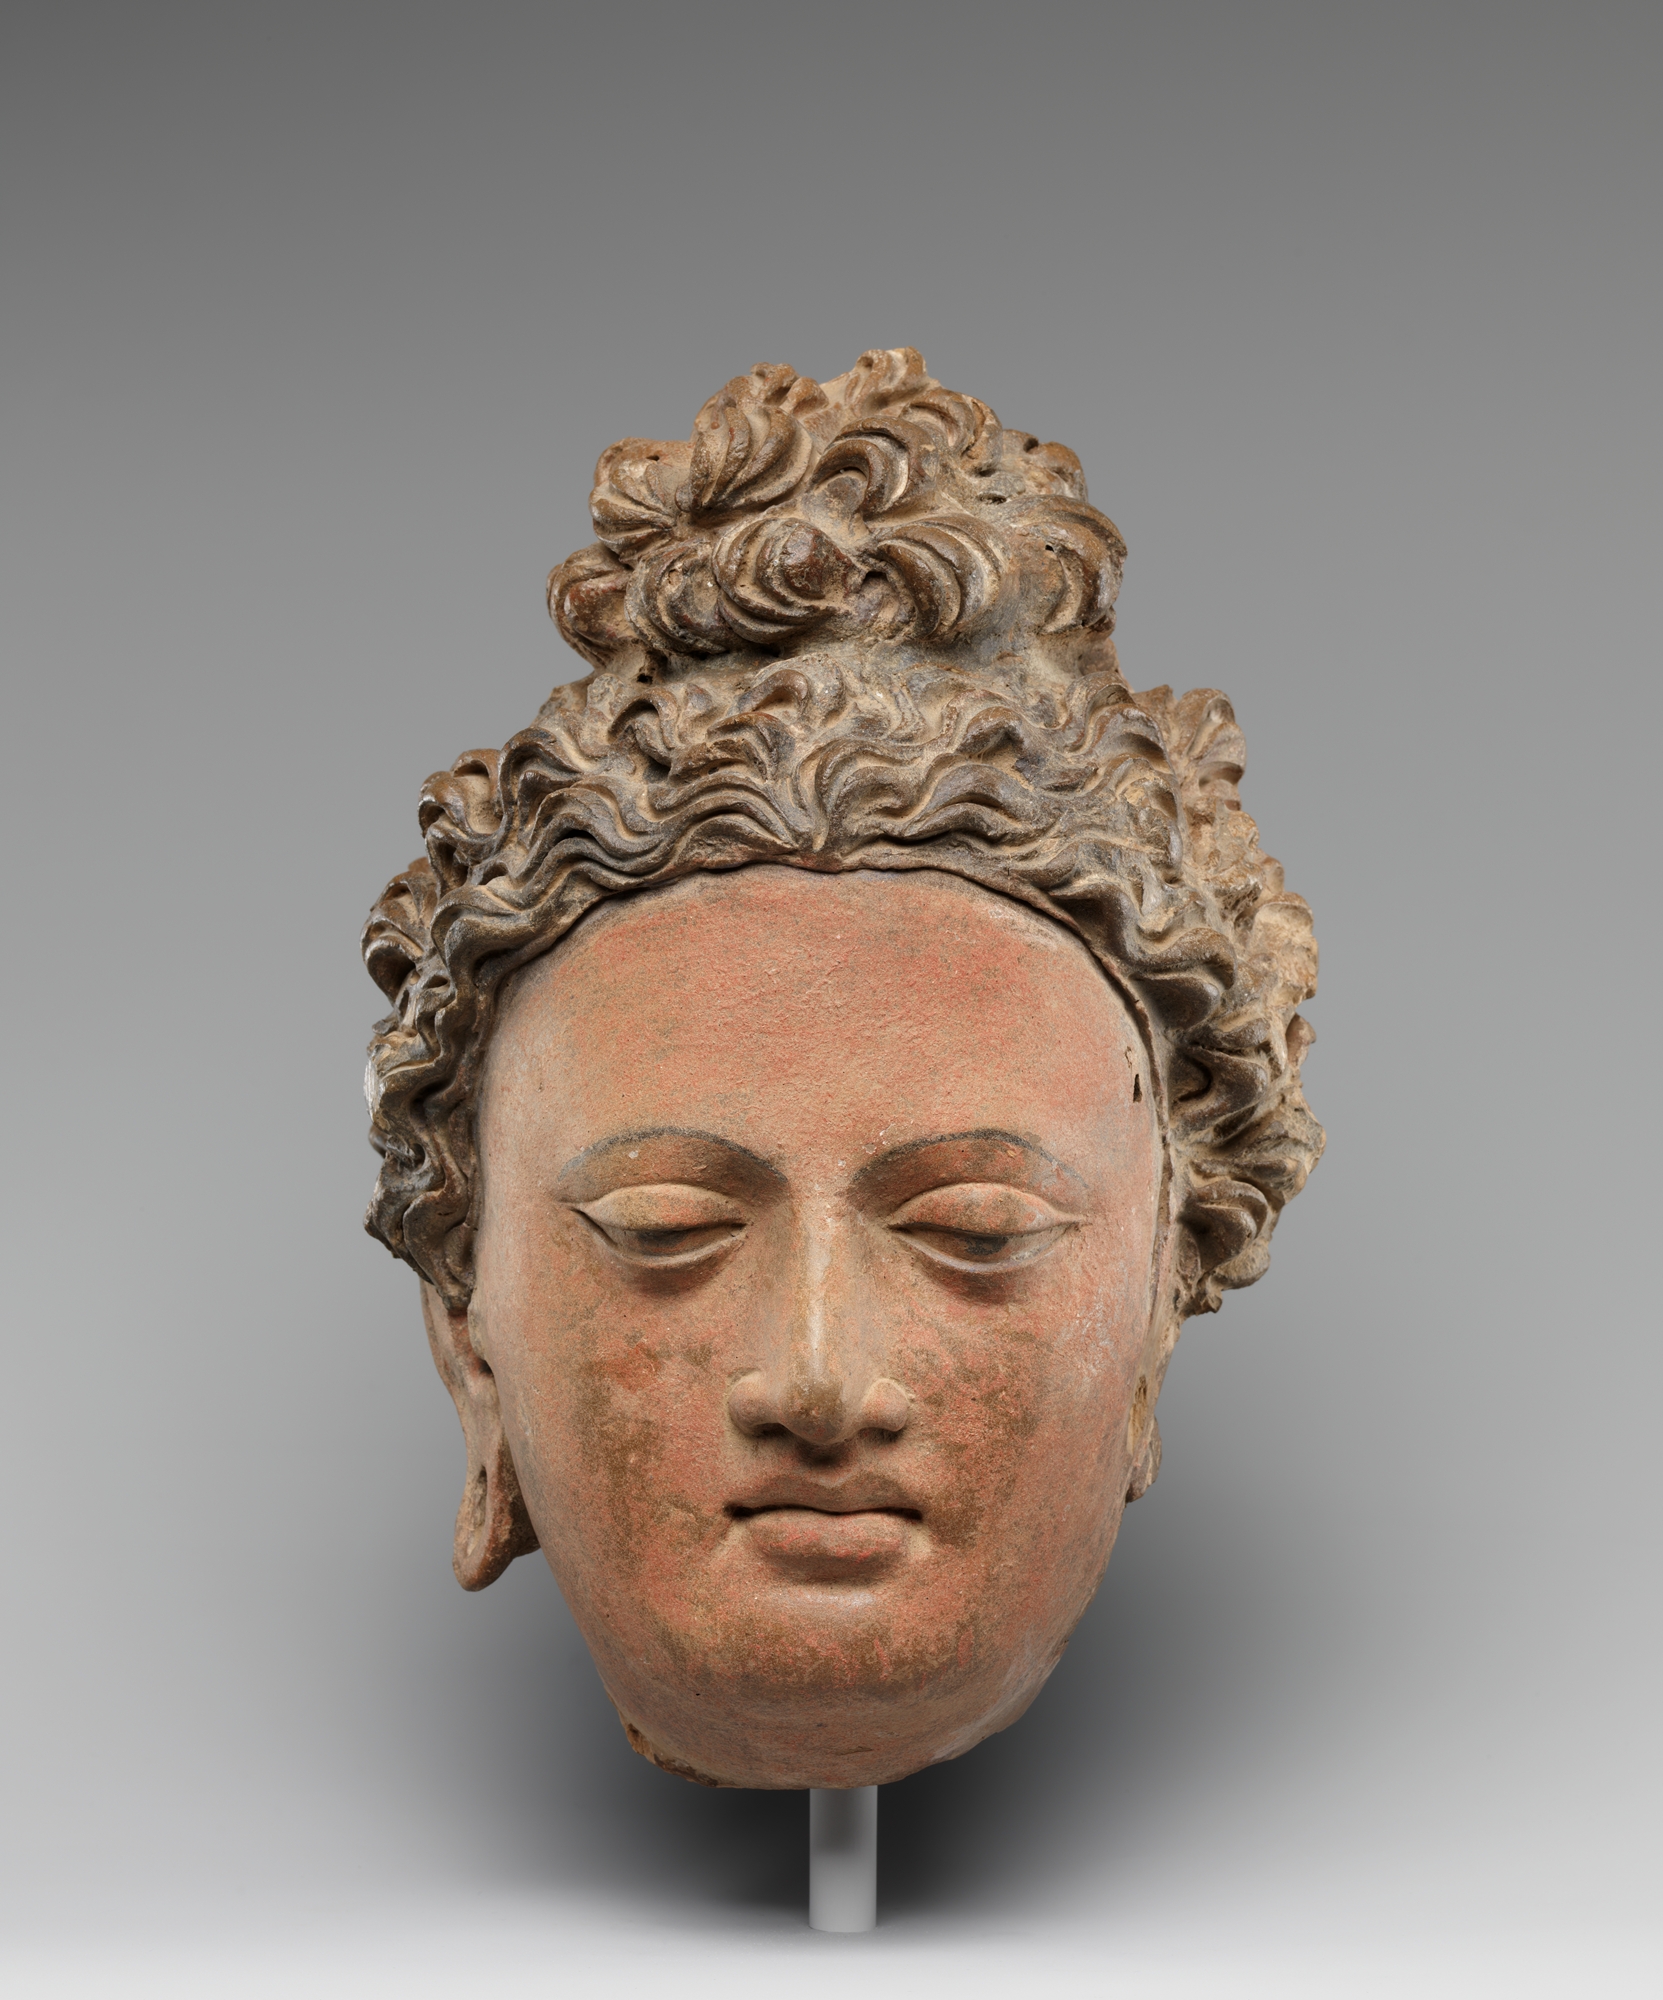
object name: head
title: Head of a Buddha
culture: afghanistan or gandhara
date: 201-400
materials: clay, pigment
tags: gandhara,heads,buddha